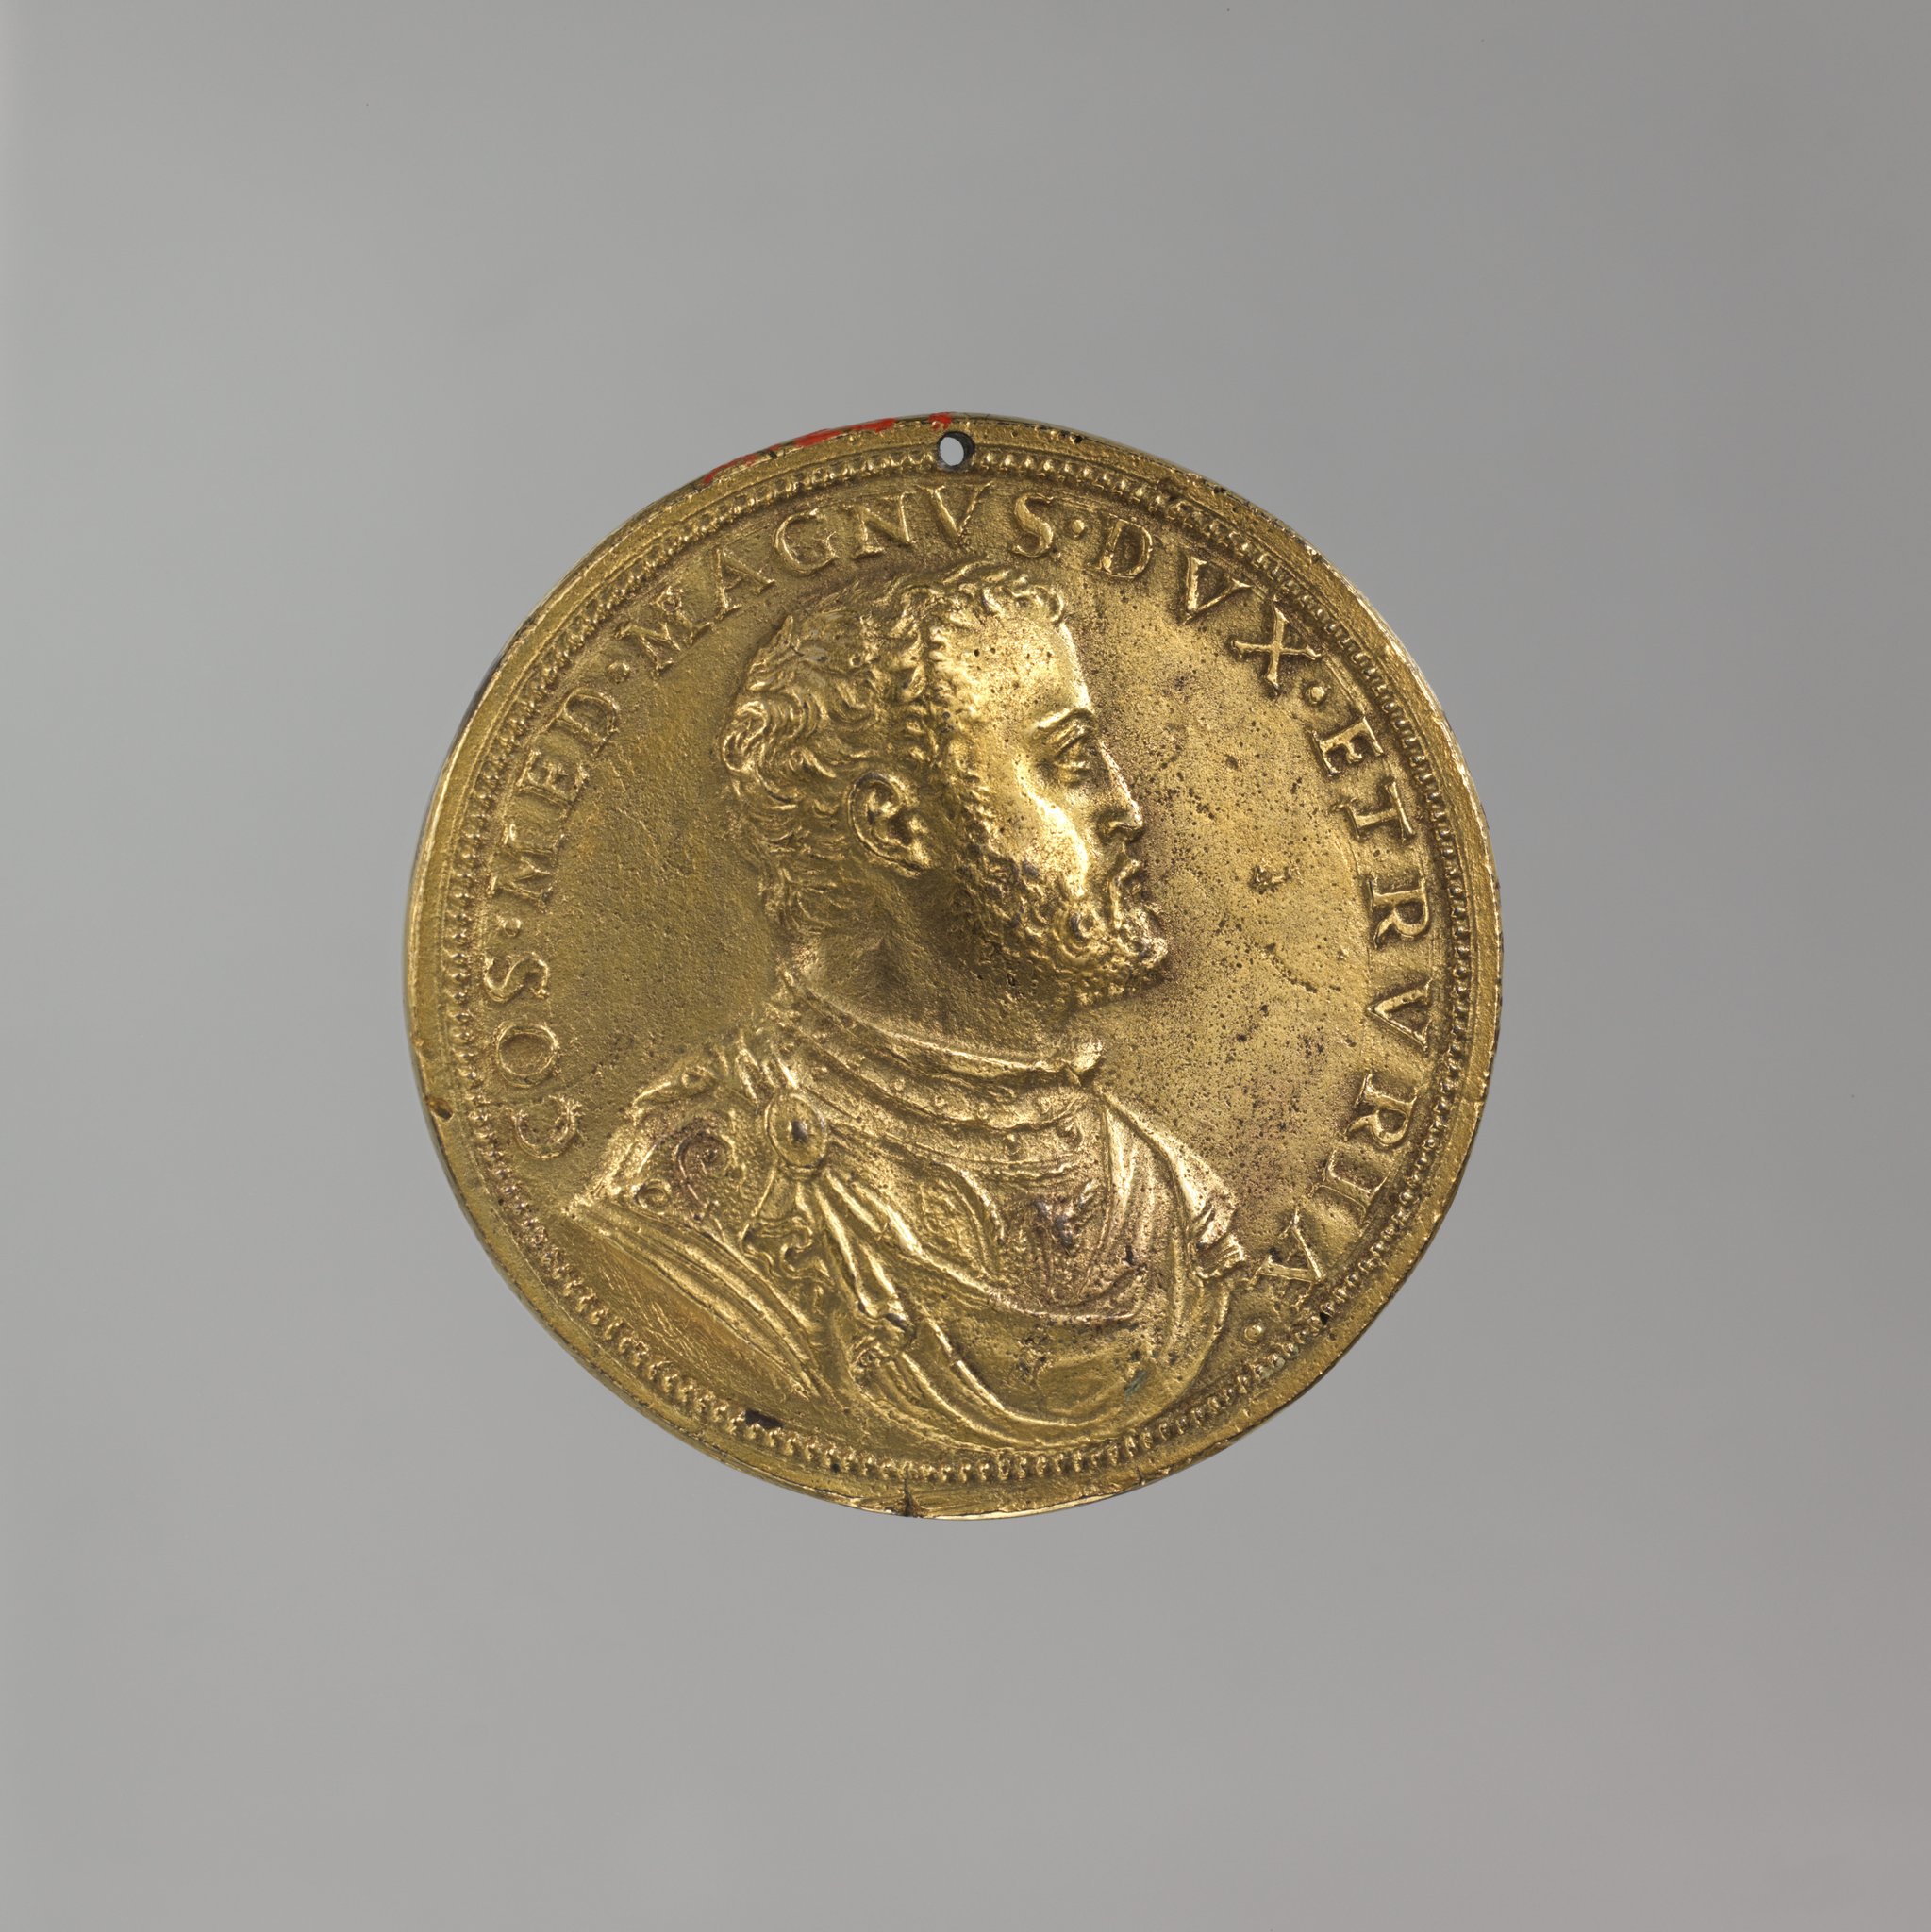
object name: medal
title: Cosimo I of Tuscany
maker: domenico di polo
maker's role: artist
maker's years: 1500-1600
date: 1501-1600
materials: gilt, metal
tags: men,profiles